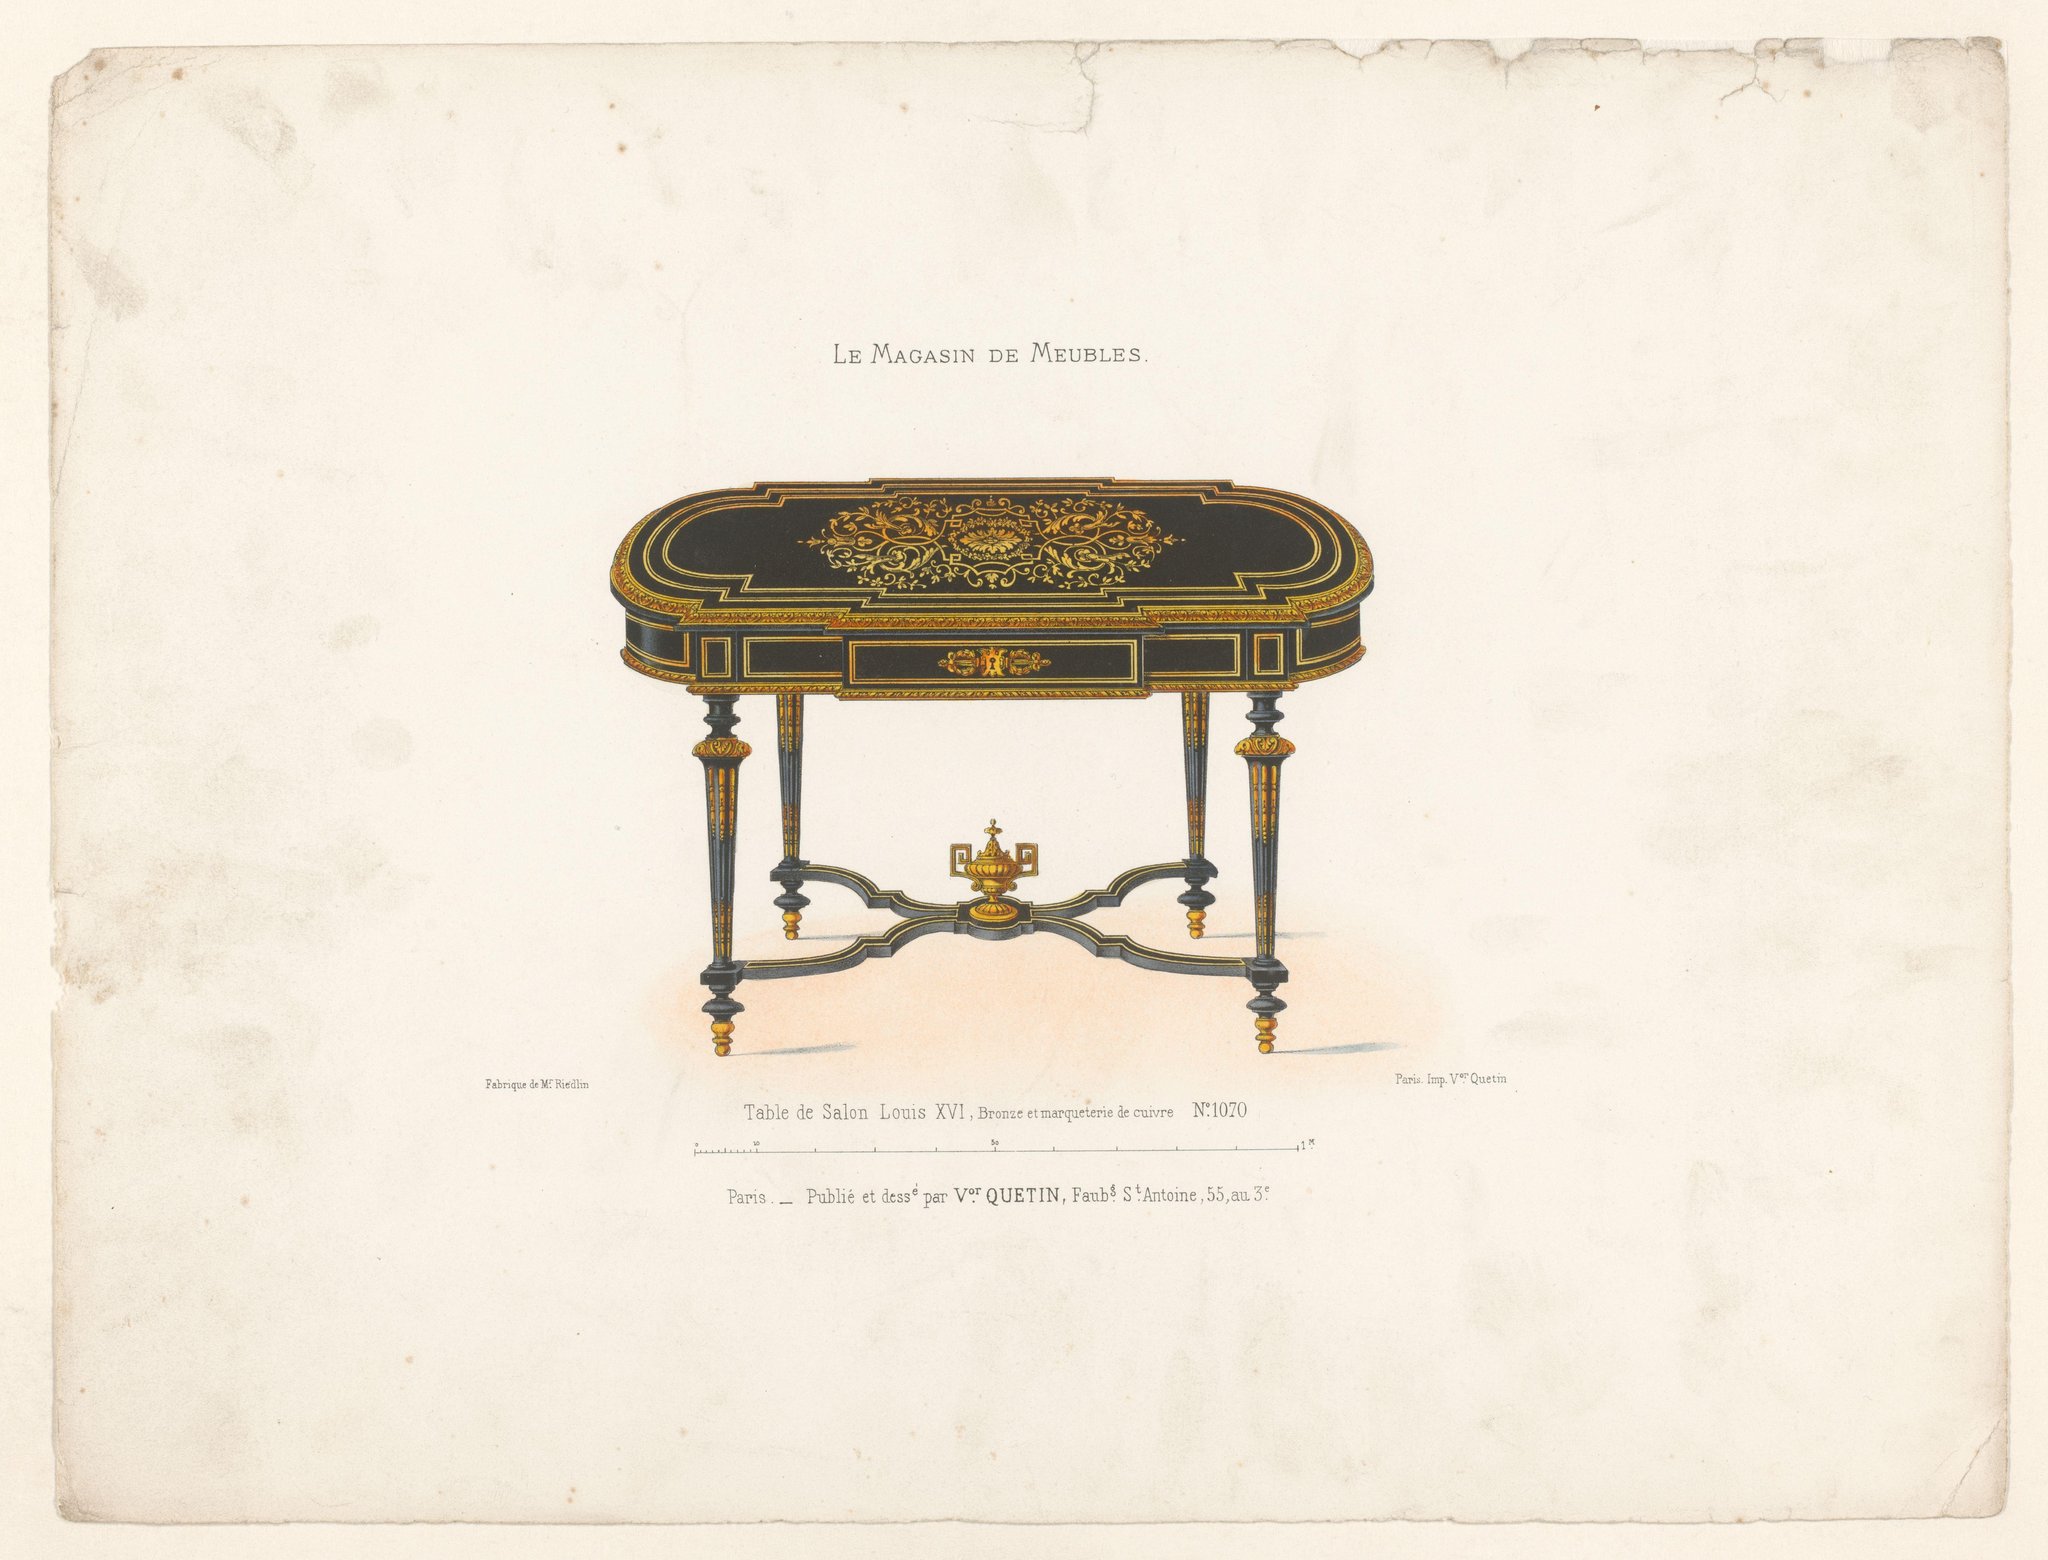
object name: print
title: Table de Salon Louis XVI, Bronze et marqueterie de cuivre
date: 1832-1877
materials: paper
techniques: hand coloring, lithograph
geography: paris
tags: table